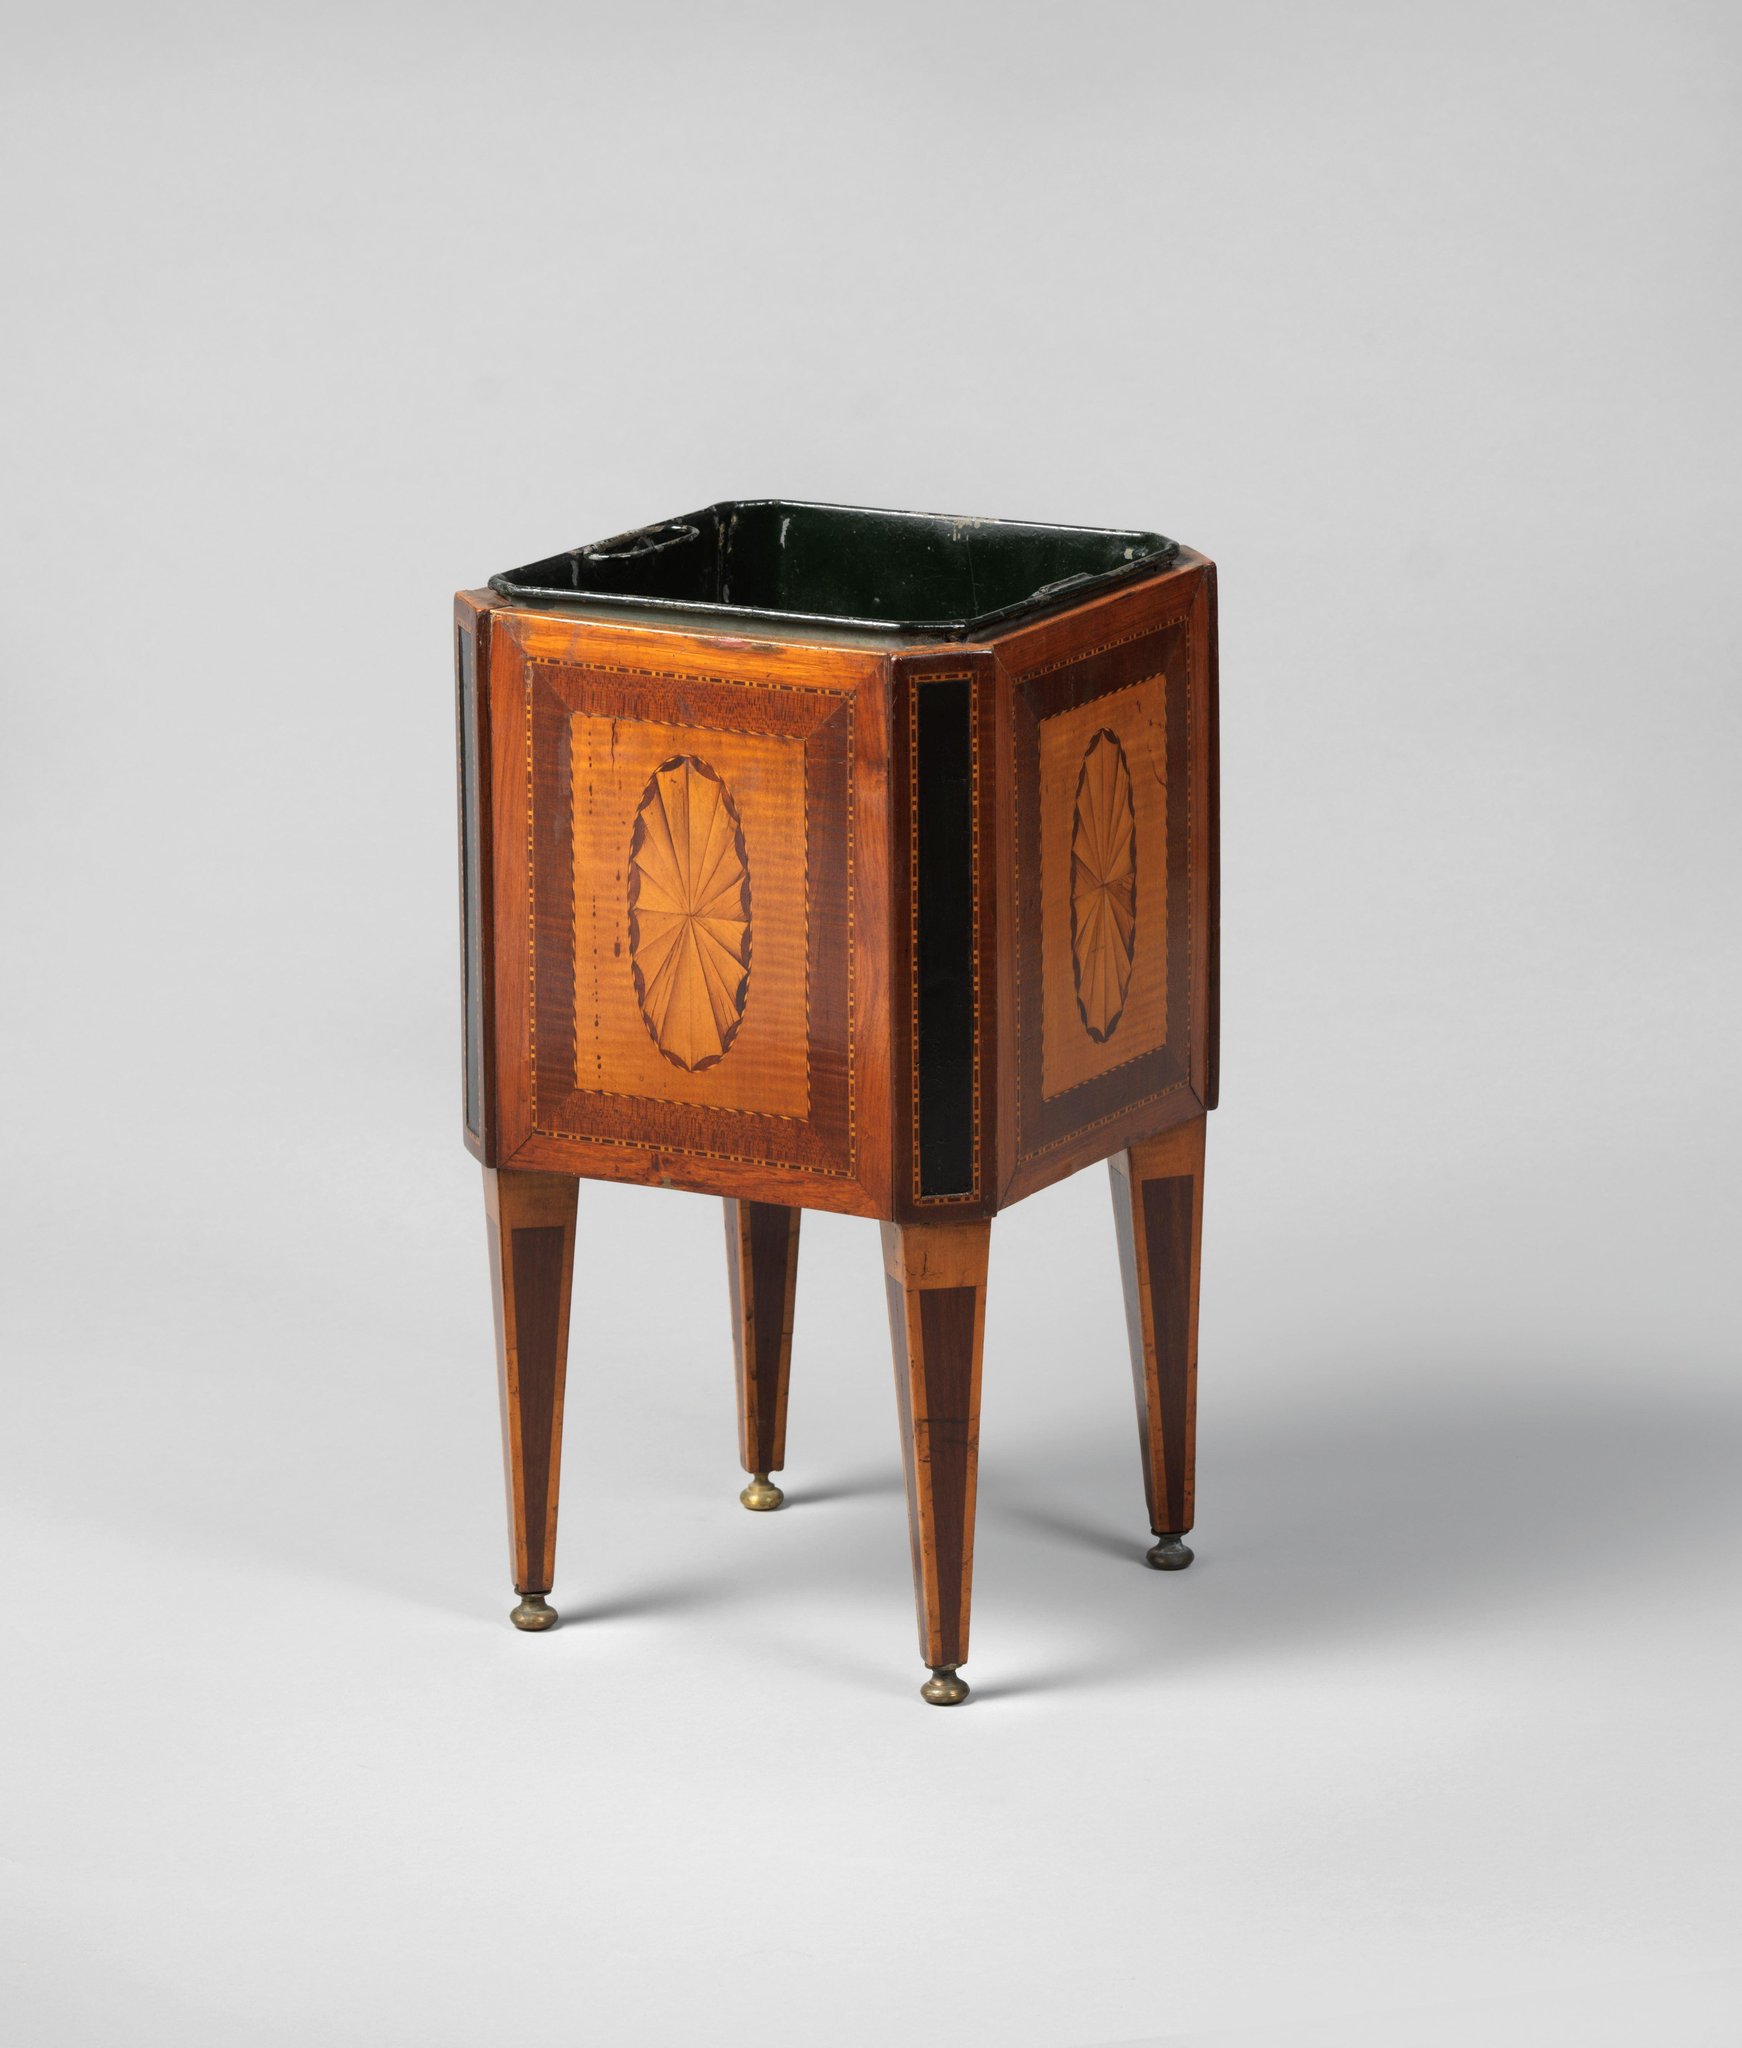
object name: heating system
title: Theestoof, versierd met waaiermotief in marqueterie.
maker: Anonymous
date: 1775-1800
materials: wood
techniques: marquetry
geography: northern netherlands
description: Vierkante theestoof van eikenhout, belijmd met andere houtsoorten. De stoof met afgeschuinde hoeken rust op vier conische poten en vertoont panelen, die in het midden een ovaalvormig waaiermotief in marqueterie vertonen.